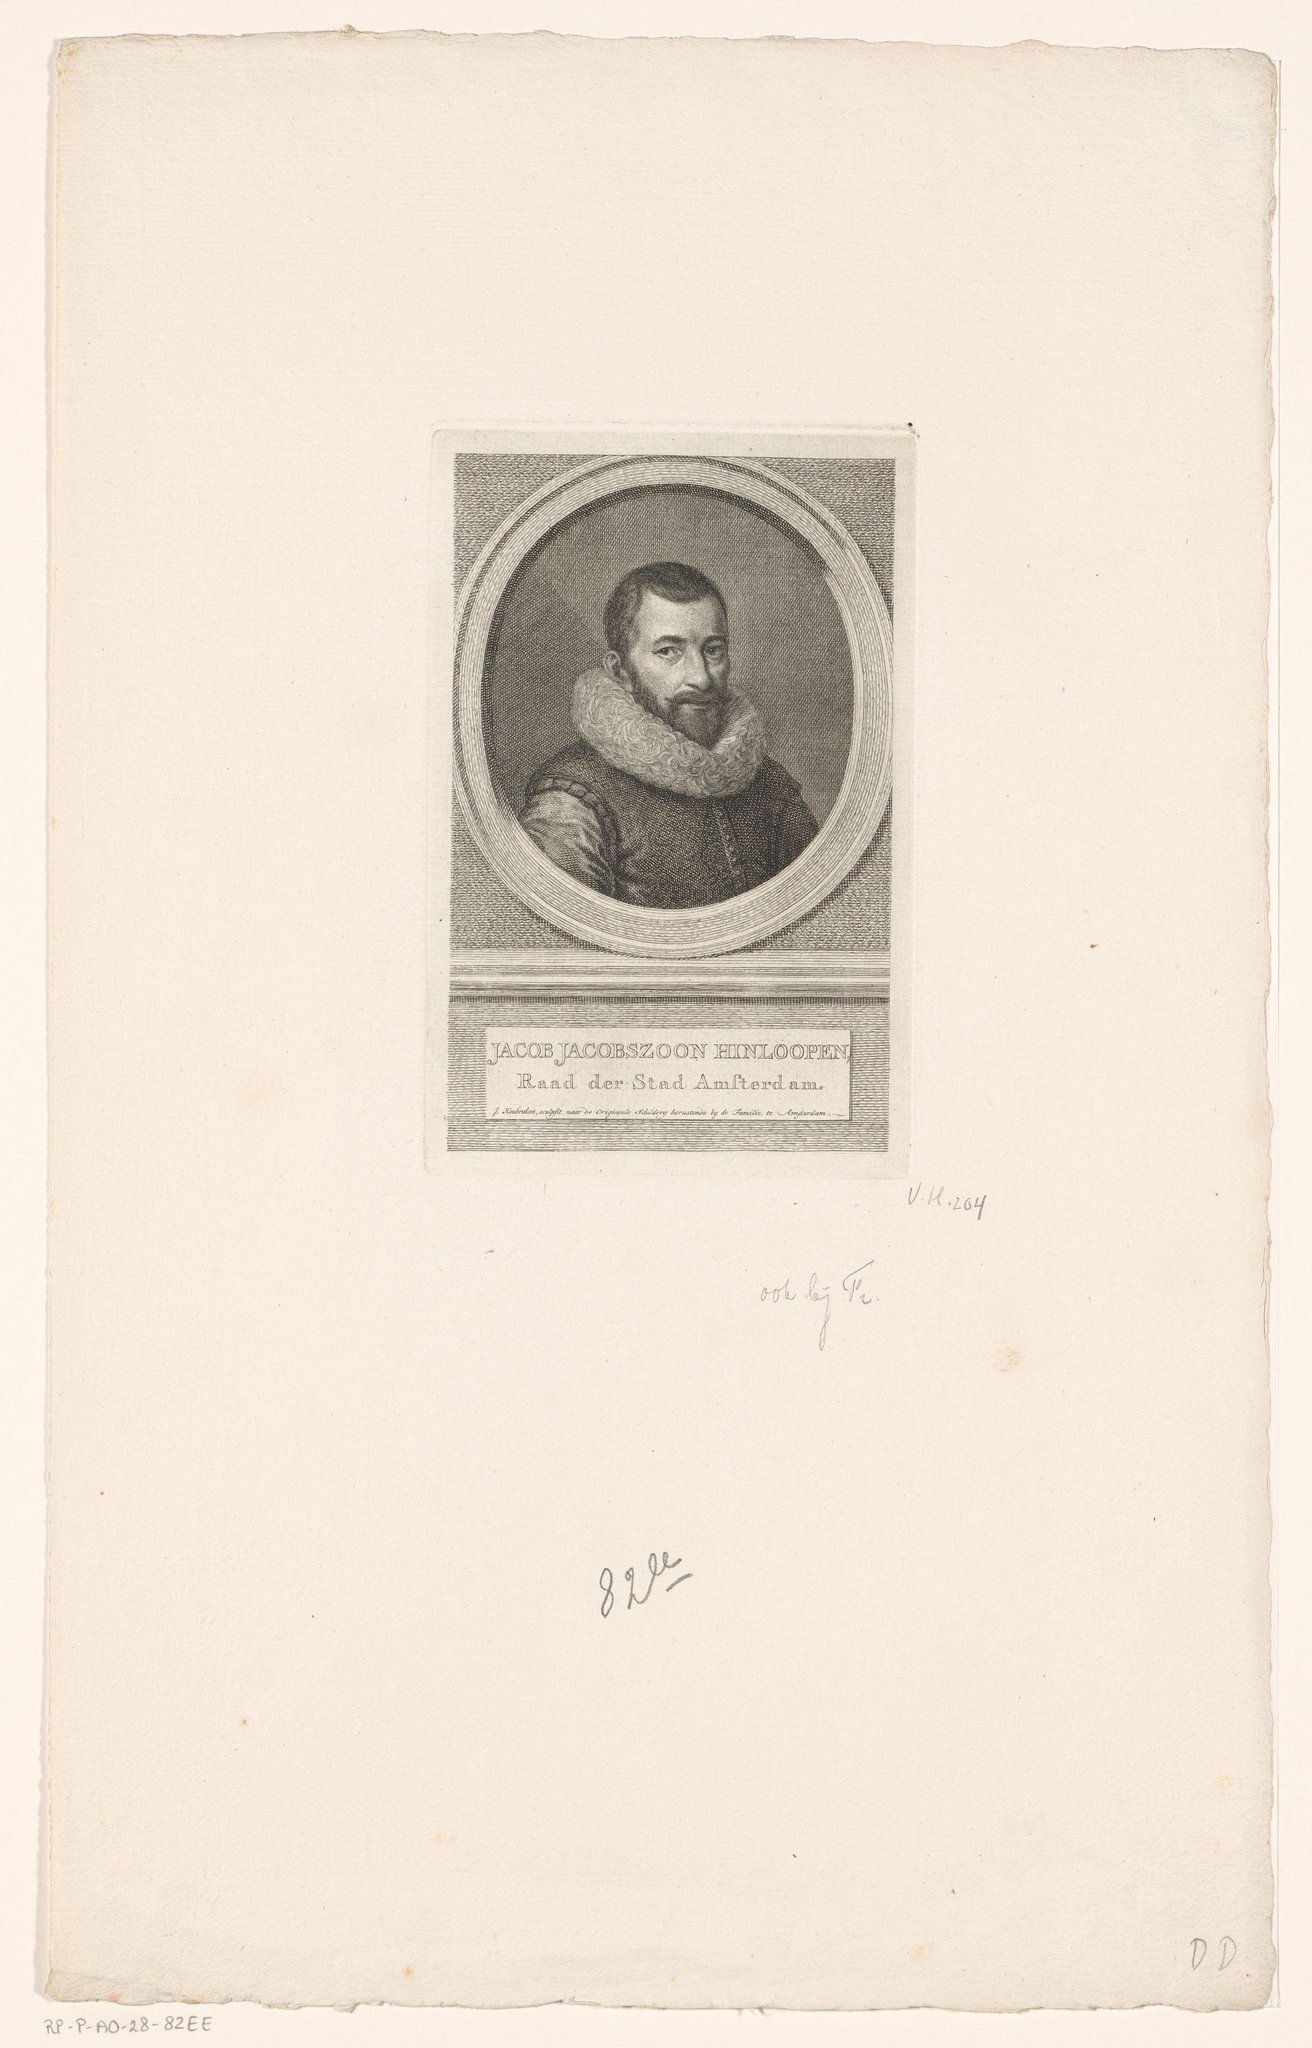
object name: print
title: Portret van Jacob Jacobszoon Hinlopen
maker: jacob houbraken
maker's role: draughtsman, print maker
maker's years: 1698-1780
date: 1749-1780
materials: paper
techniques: engraving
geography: amsterdam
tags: historical persons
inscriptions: collector's mark: Lugt 2228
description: Deze prent is oorspronkelijk bedoeld als aanvulling op Jan Wagenaars ‘Vaderlandsche historie’* en was zo vanaf 1796 verkrijgbaar bij Johannes Allart te Amsterdam. Voor de advertentie waarin Allart de 60 portretten en 7 platen, allen gegraveerd door Houbraken, ter aanvulling op Wagenaars ‘Vaderlandsche historie’ aanbiedt, zie RP-P-OB-77.766. *Van dit werk zijn in de achttiende eeuw meerdere uitgaves verschenen, zoals: Wagenaar, Jan. Vaderlandsche historie, vervattende de geschiedenissen der Vereenigde Nederlanden (…). 21 delen. Amsterdam: Isaak Tirion, 1749-1759. Wagenaar, Jan. Vaderlandsche historie, vervattende de geschiedenissen der nu Vereenigde Nederlanden (…). 21 delen. Amsterdam: weduwe Isaak Tirion, 1770. Wagenaar, Jan. Vaderlandsche historie, vervattende de geschiedenissen der nu Vereenigde Nederlanden (…). 21 delen. Amsterdam, Leiden, Dordrecht en Harlingen: P. Schouten e.a., 1782. Wagenaar, Jan. Vaderlandsche historie, vervattende de geschiedenissen der nu Vereenigde Nederlanden (…). 21 delen. Amsterdam: Johannes Allart, 1790-1796.